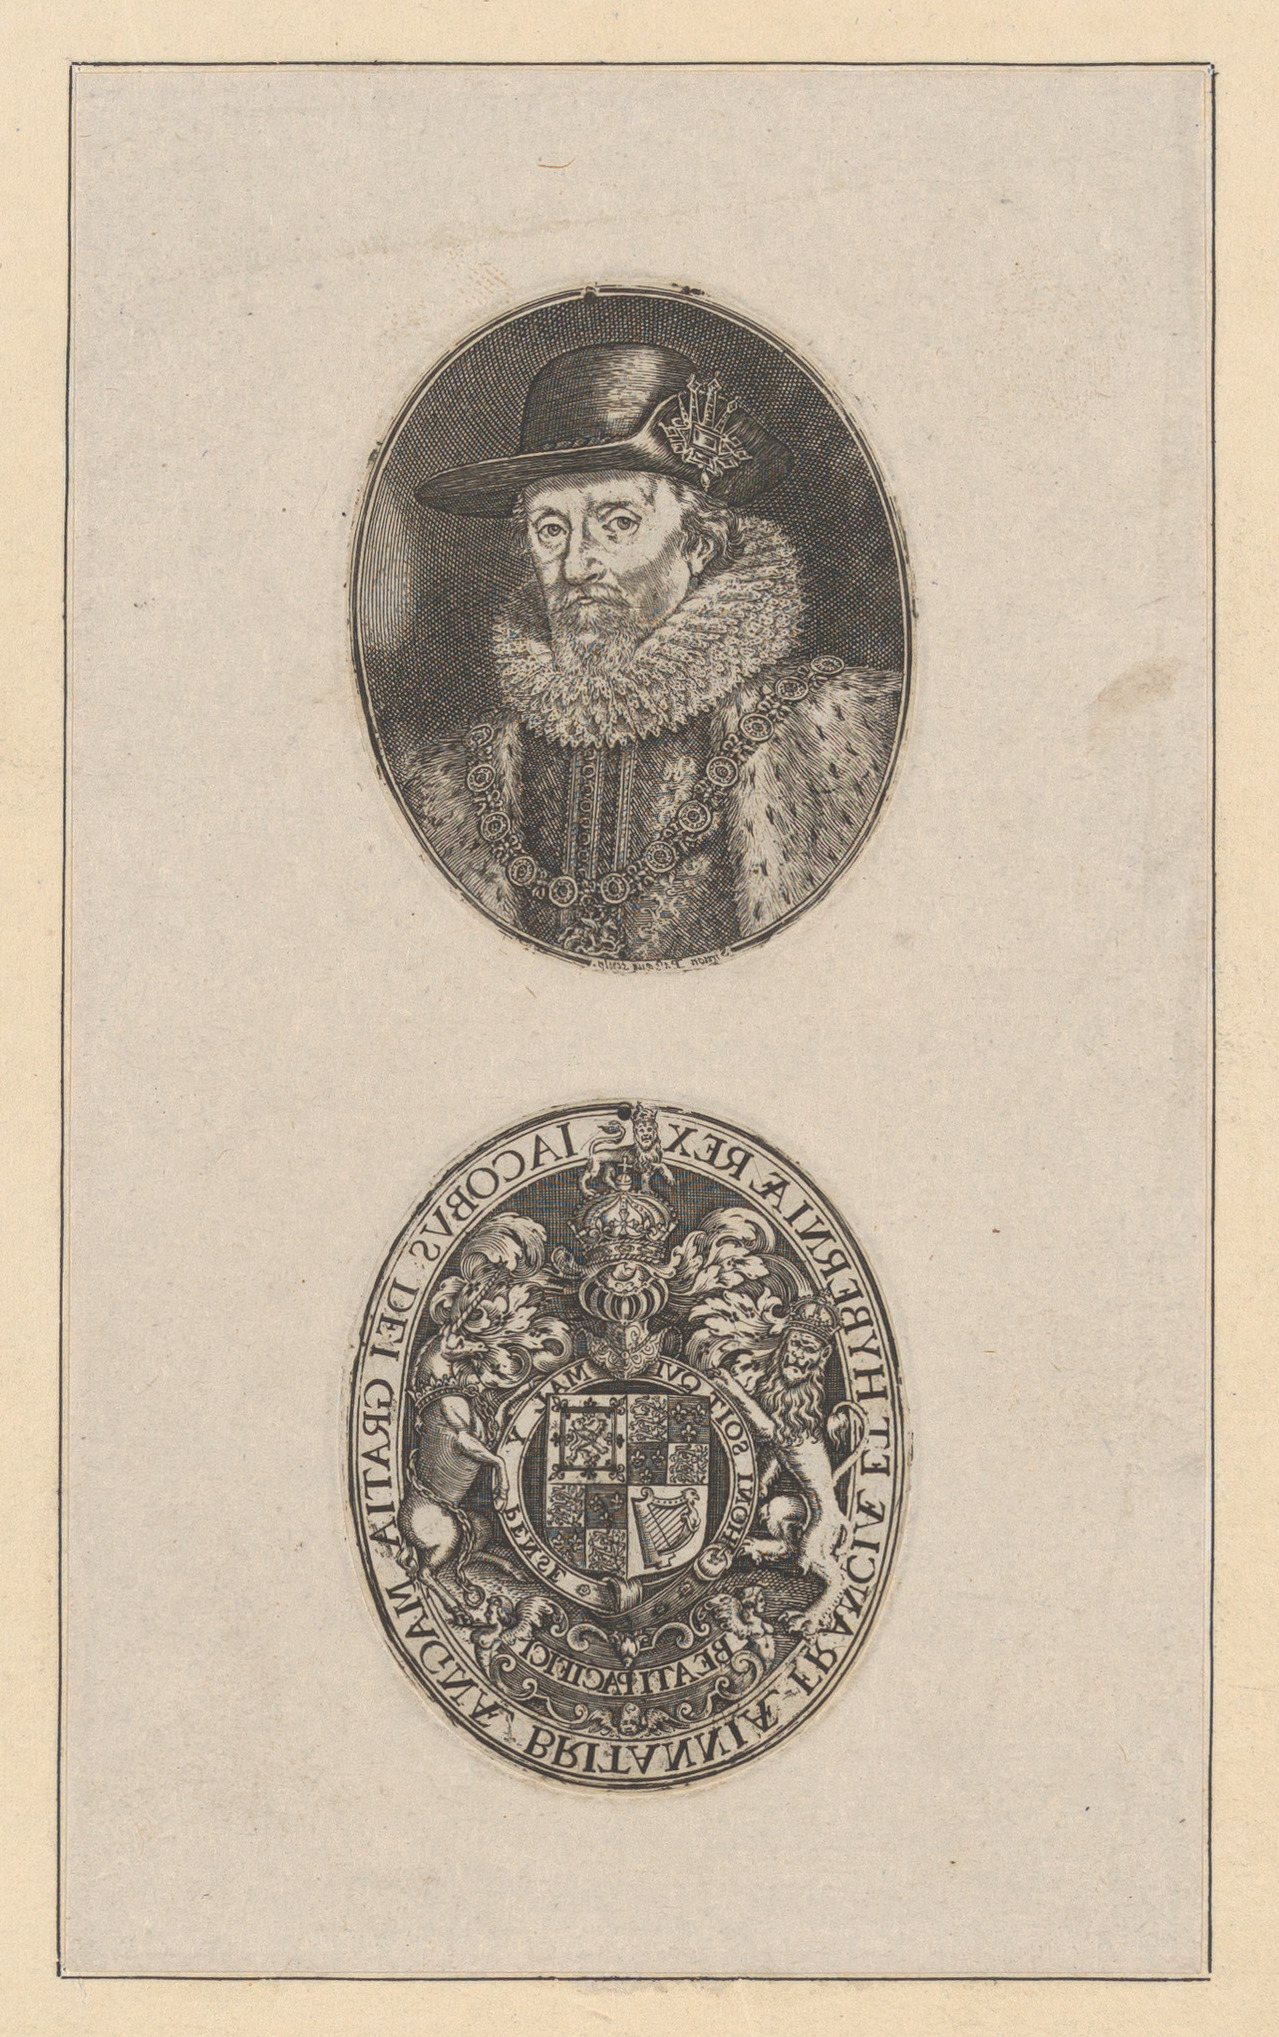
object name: print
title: James I, King of England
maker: simon de passe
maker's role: artist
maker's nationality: dutch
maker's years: 1590-1647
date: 1616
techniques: engraving, printing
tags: kings,portraits,coat of arms